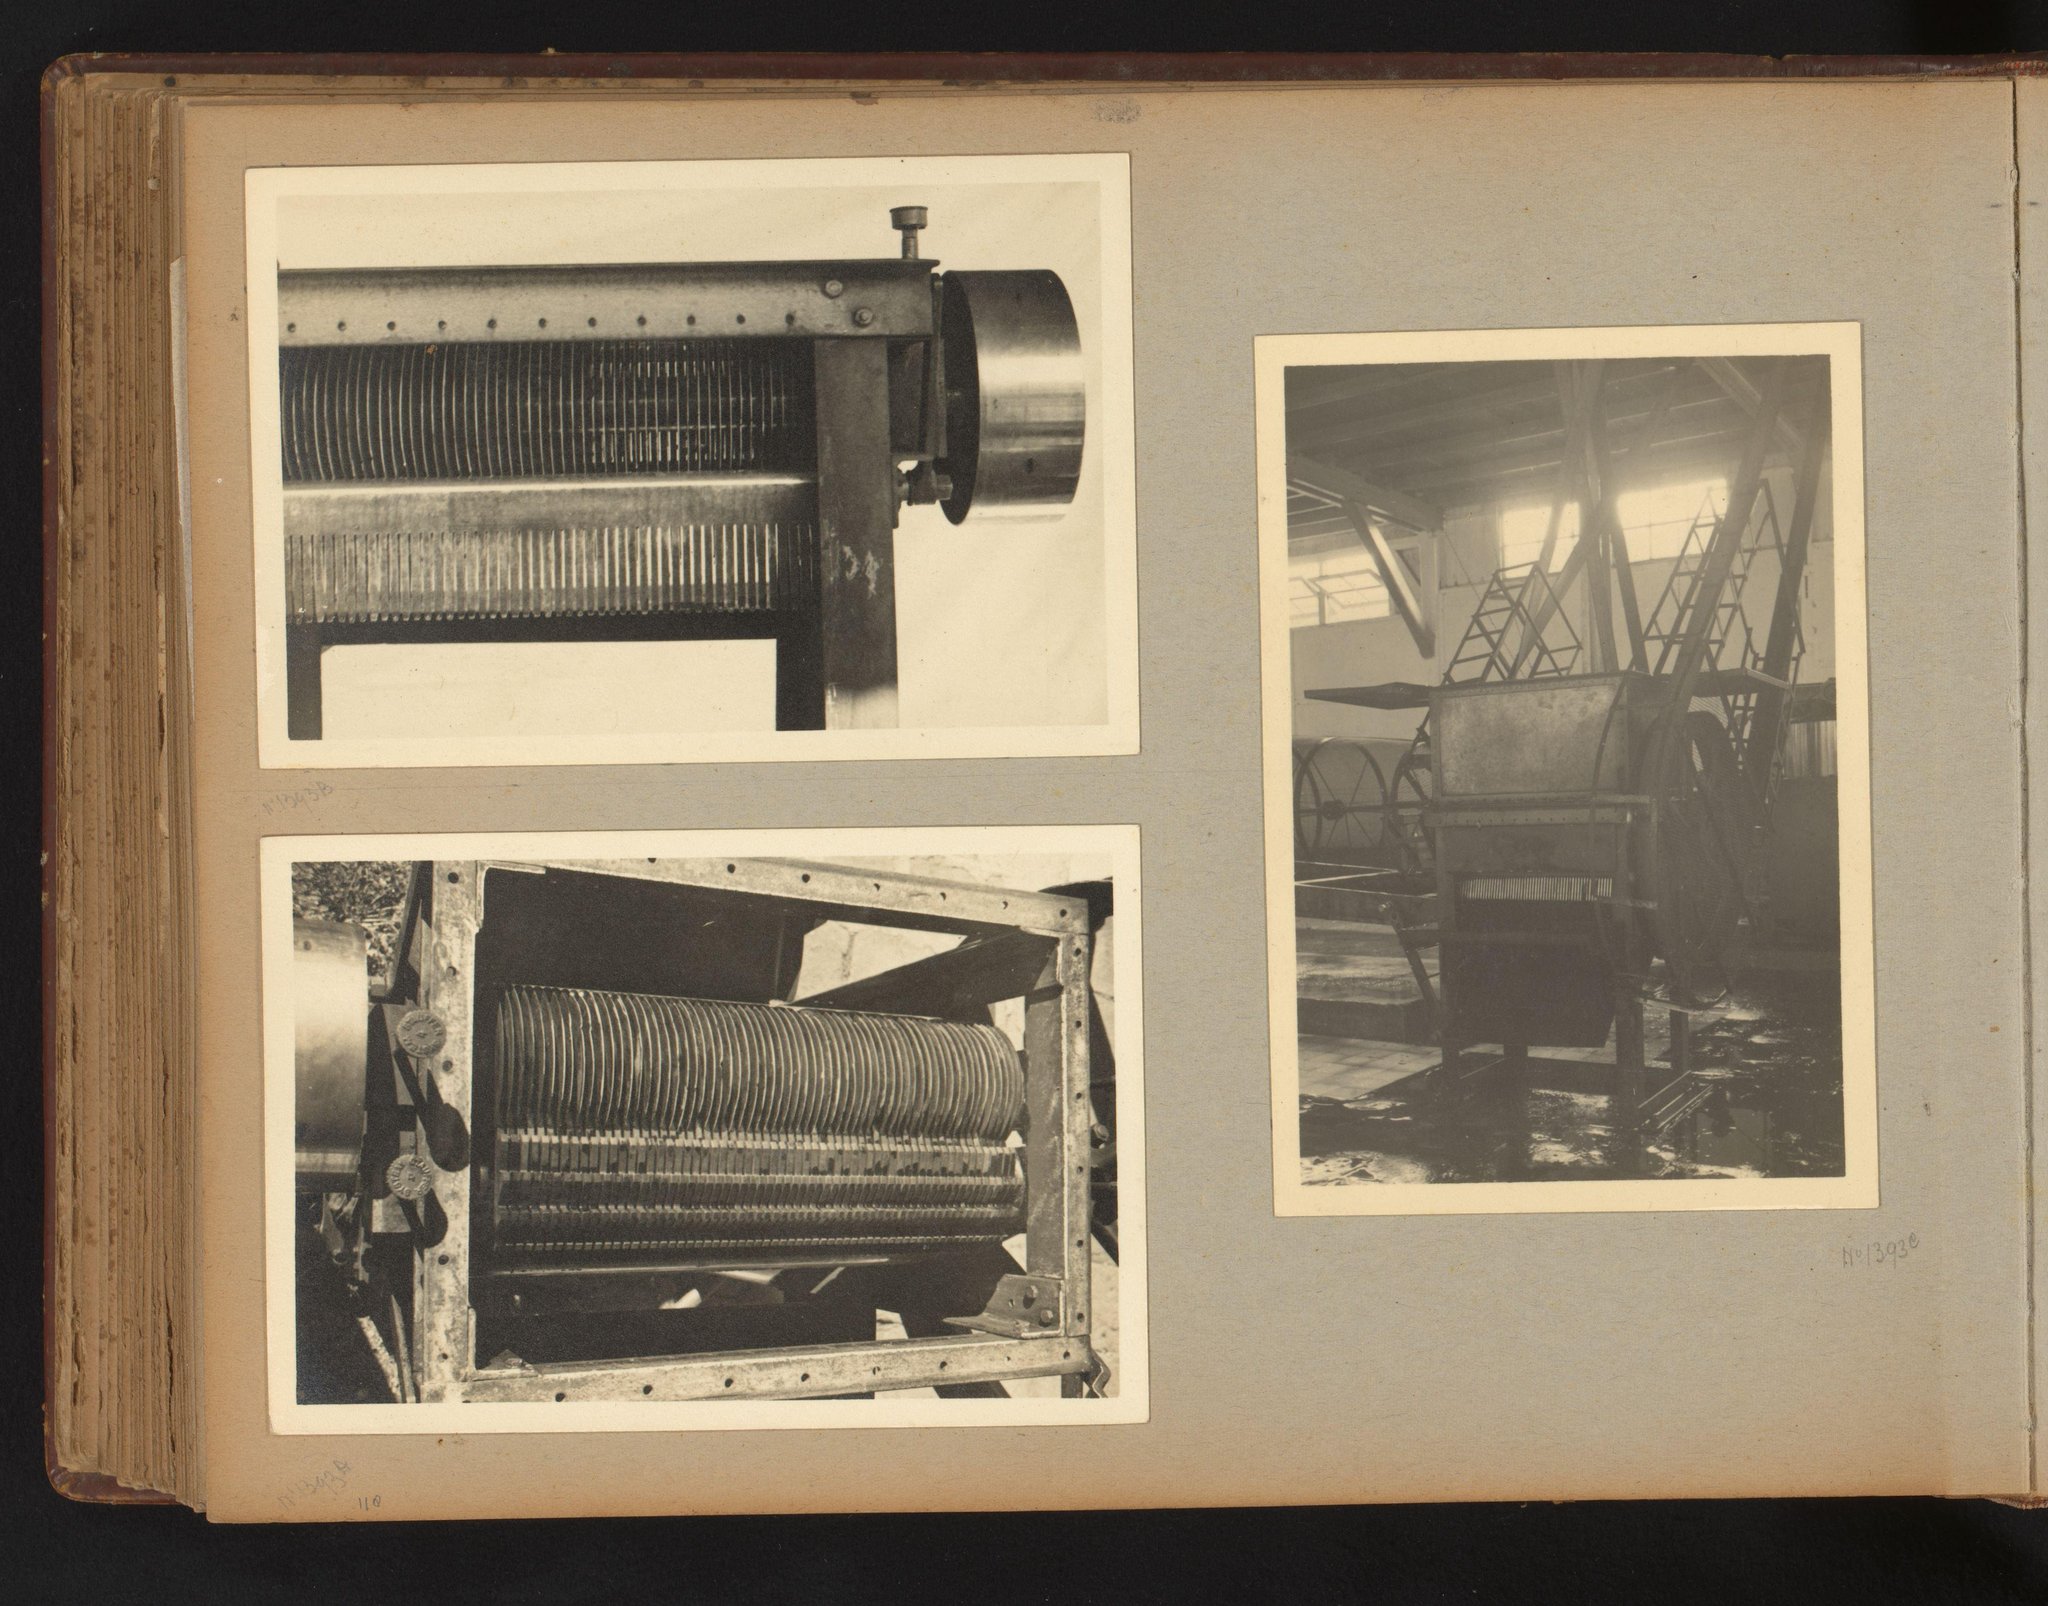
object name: photograph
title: Machine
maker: Anonymous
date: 1931-1937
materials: cardboard, photographic support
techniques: gelatin silver print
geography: java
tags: machines; parts of machines; tools and appliances, java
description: Albumblad met drie foto's van een machine. Onderdeel van een fotoalbum met foto's van machines en constructies van de N.V. Machinefabriek Braat te Soerabaja, Soekaboemi en Tegal uit de periode 1931-1937.